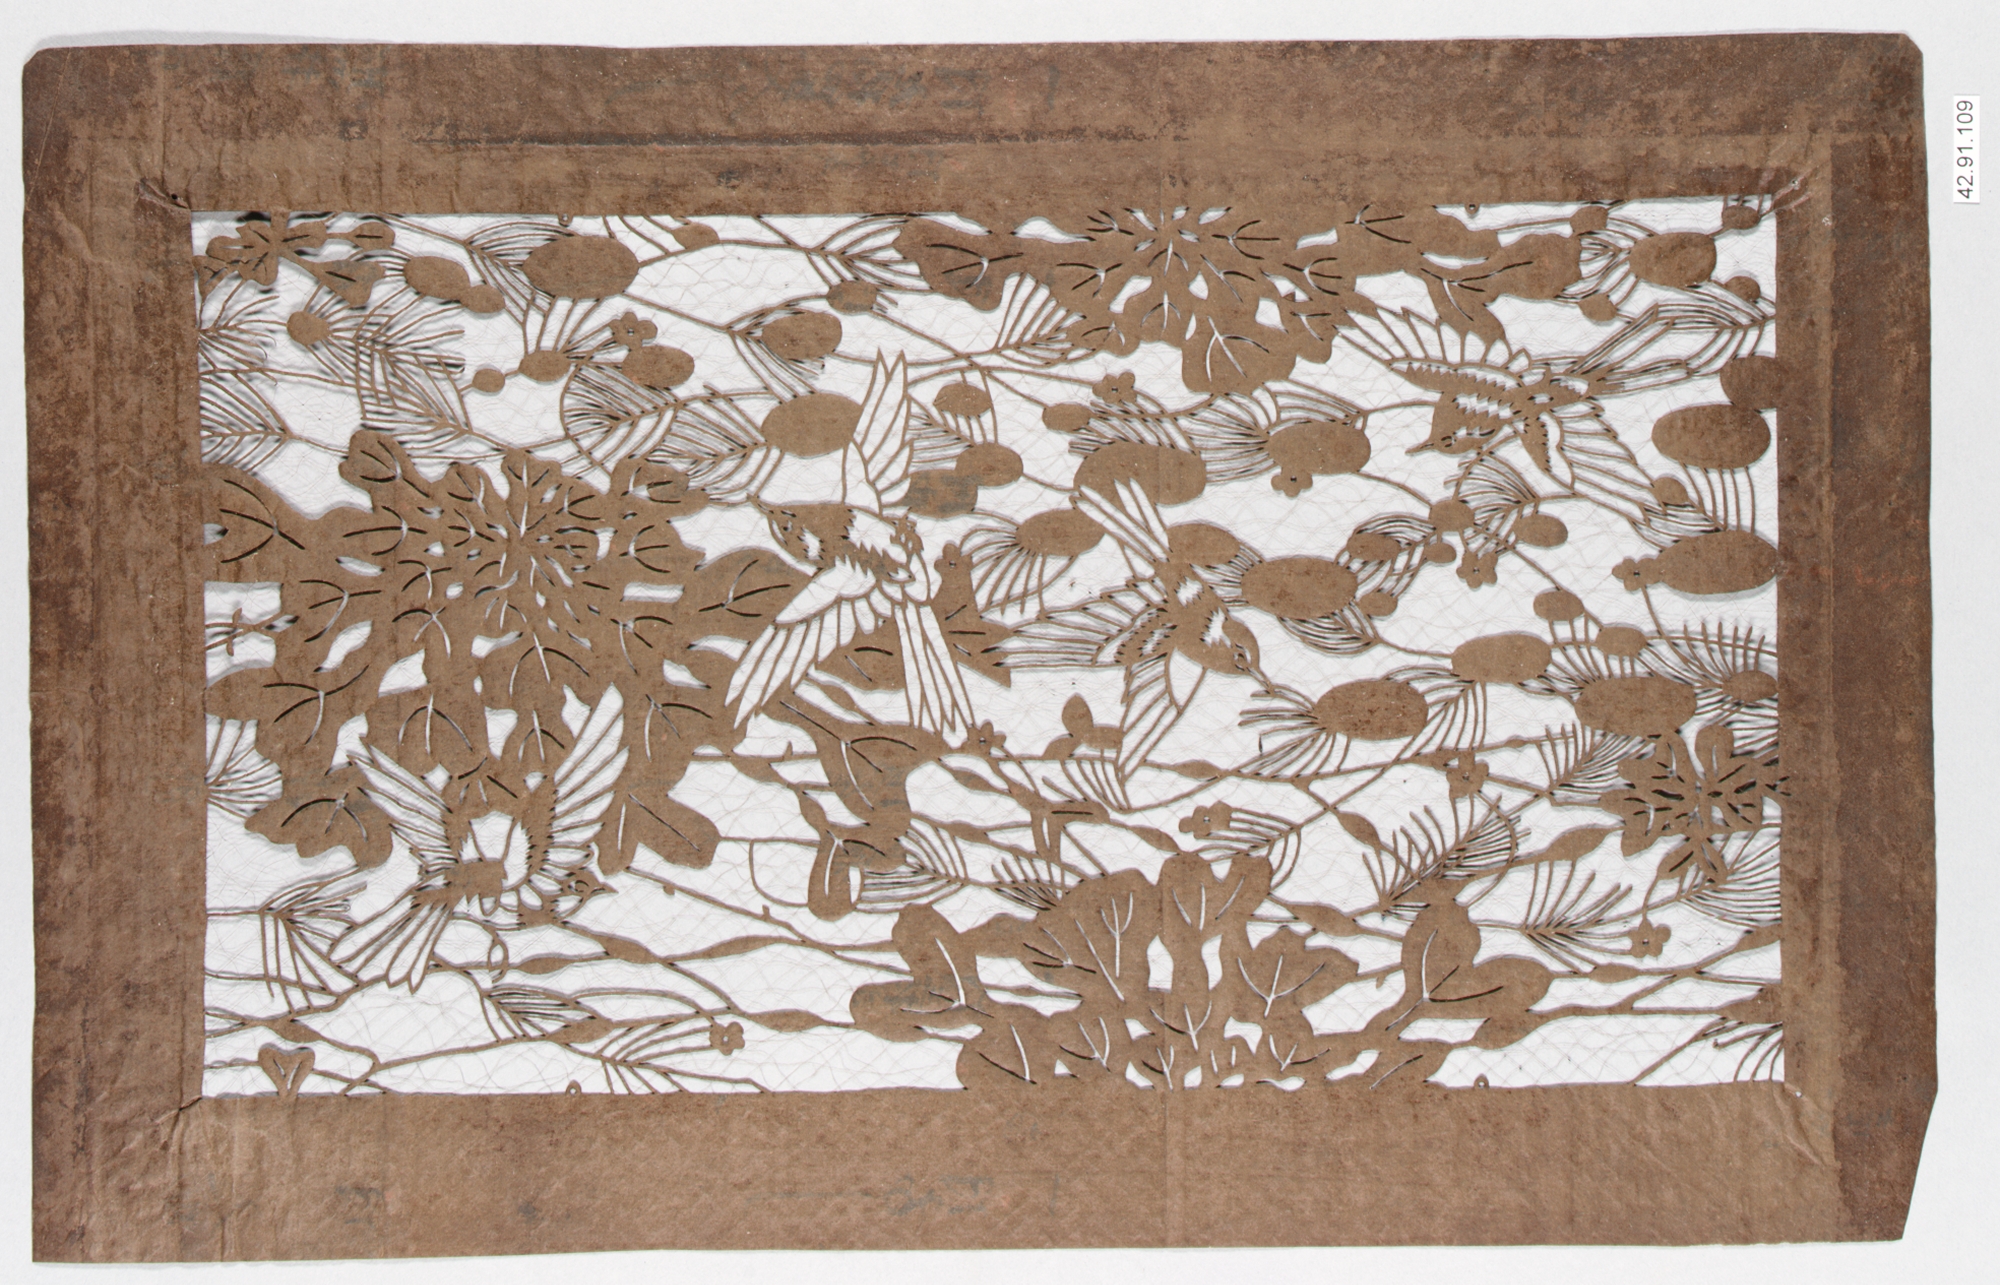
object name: stencil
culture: japanese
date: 1801-1900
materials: paper, silk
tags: birds